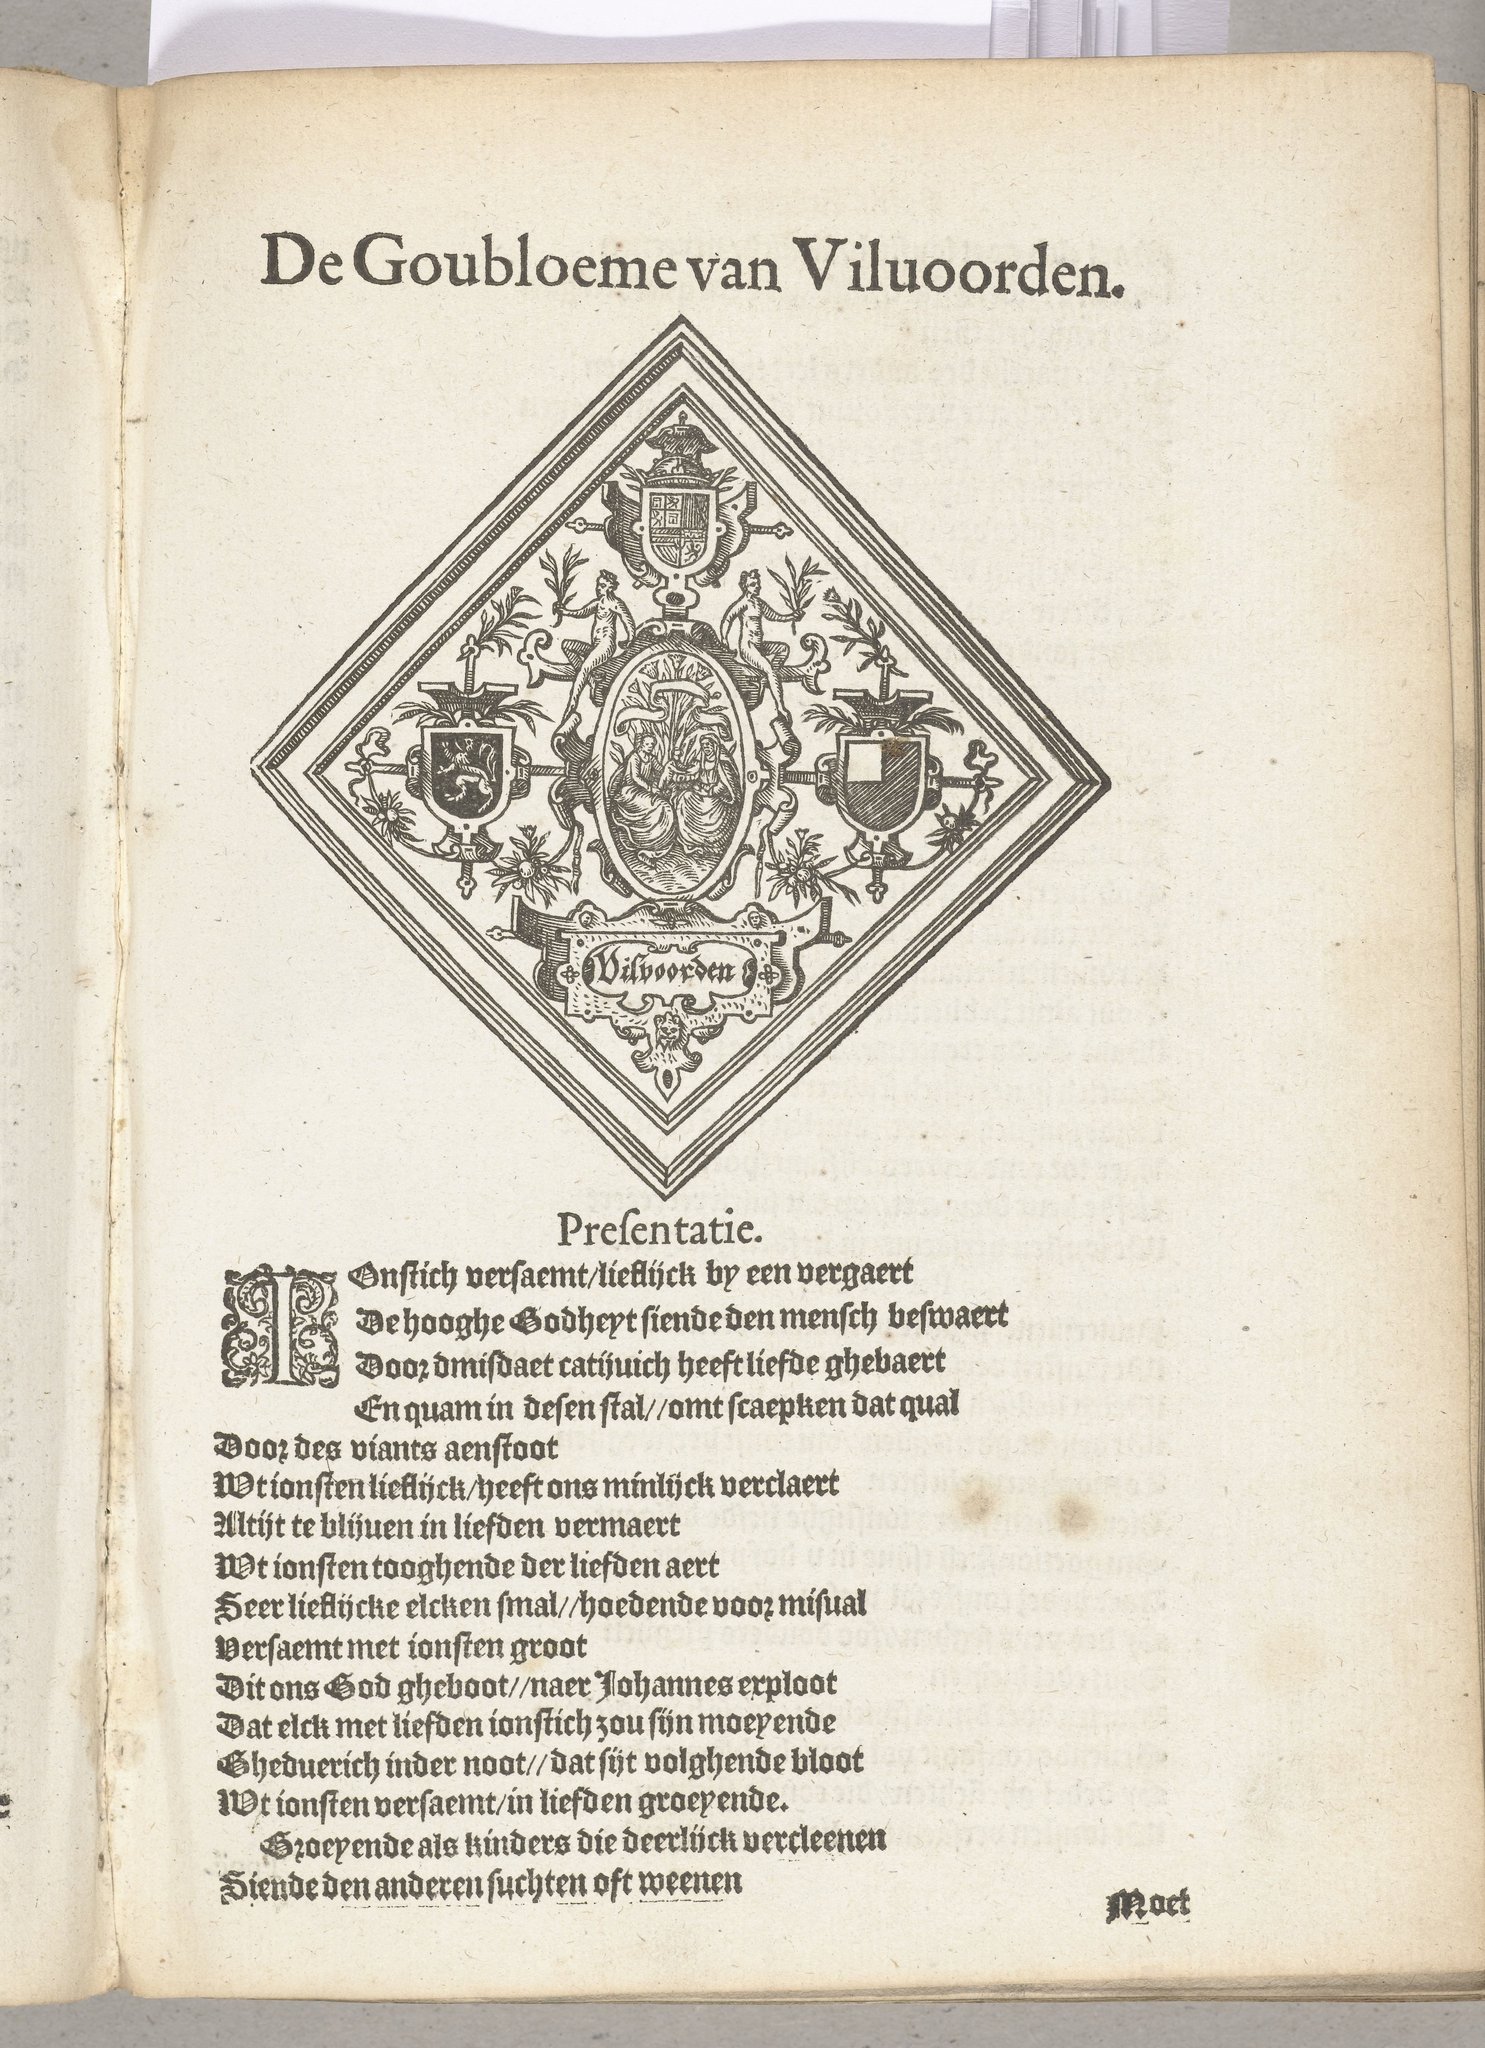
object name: print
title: Vertoning van De Goudbloem (Vilvoorde), 1561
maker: Anonymous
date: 1561-1562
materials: paper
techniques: woodcut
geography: antwerp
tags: theatre, theatrical performance, chamber of rhetoric (dutch: 'rederijkerskamer'), antwerp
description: Illustratie in: Spelen van sinne vol scoone moralisacien wtleggingen ende bediedenissen op alle loeflijcke consten waer inne men claerlijck ghelijck in eene spieghel, figuerlijck, poetelijck en retorijckelijck mach aenschouwen hoe nootsakelijck ende dienstelijck die selve consten allen menschen zijn : ghespeelt met octroy der Con. Ma. binnen der stadt van Andtwerpen op dLant-Juweel by die veerthien cameren van Retorijcken die hen daer ghepresenteert hebben den derden dach Augusti int Jaer ons Heeren 1561, op die questie : wat den mensch aldermeest tot conste verwect. Uitgave van 1562, p. Pp (1). In het exemplaar in de Rijksmuseum Research Library, signatuur: 325 D 20.